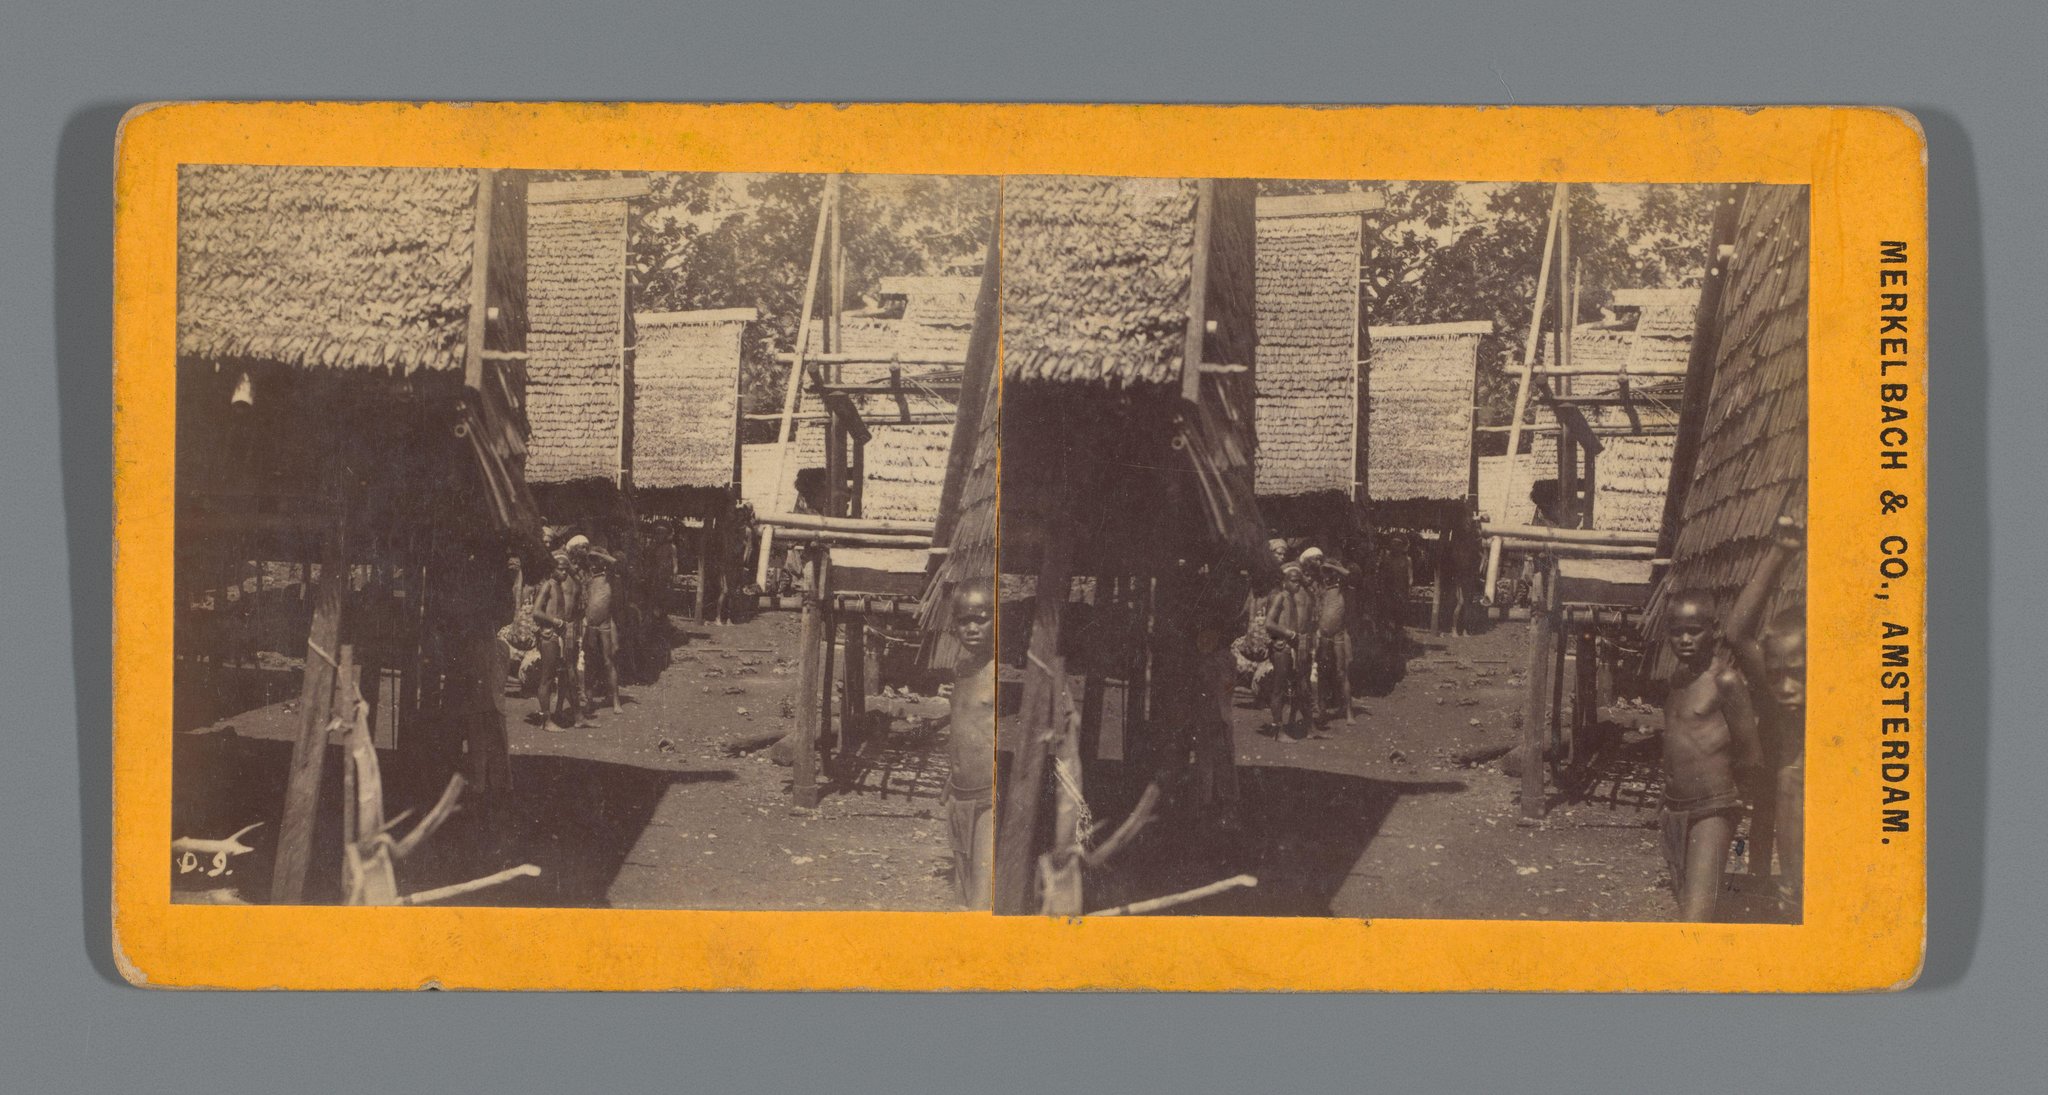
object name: stereograph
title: Aardrijkskundige Beeldengalerij, verzameld door M.J. Broekhuijsen, Hoofd eener school te Amsterdam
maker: martien johan broekhuijsen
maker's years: 1871-1956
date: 1905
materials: photographic support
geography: amsterdam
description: Onderdeel van een groep van 52 stereofoto's gebruikt in het lager onderwijs als aanvulling op schoolplaten. De gehele reeks bestond uit 274 nummers in 10 categorieën (A t/m K).